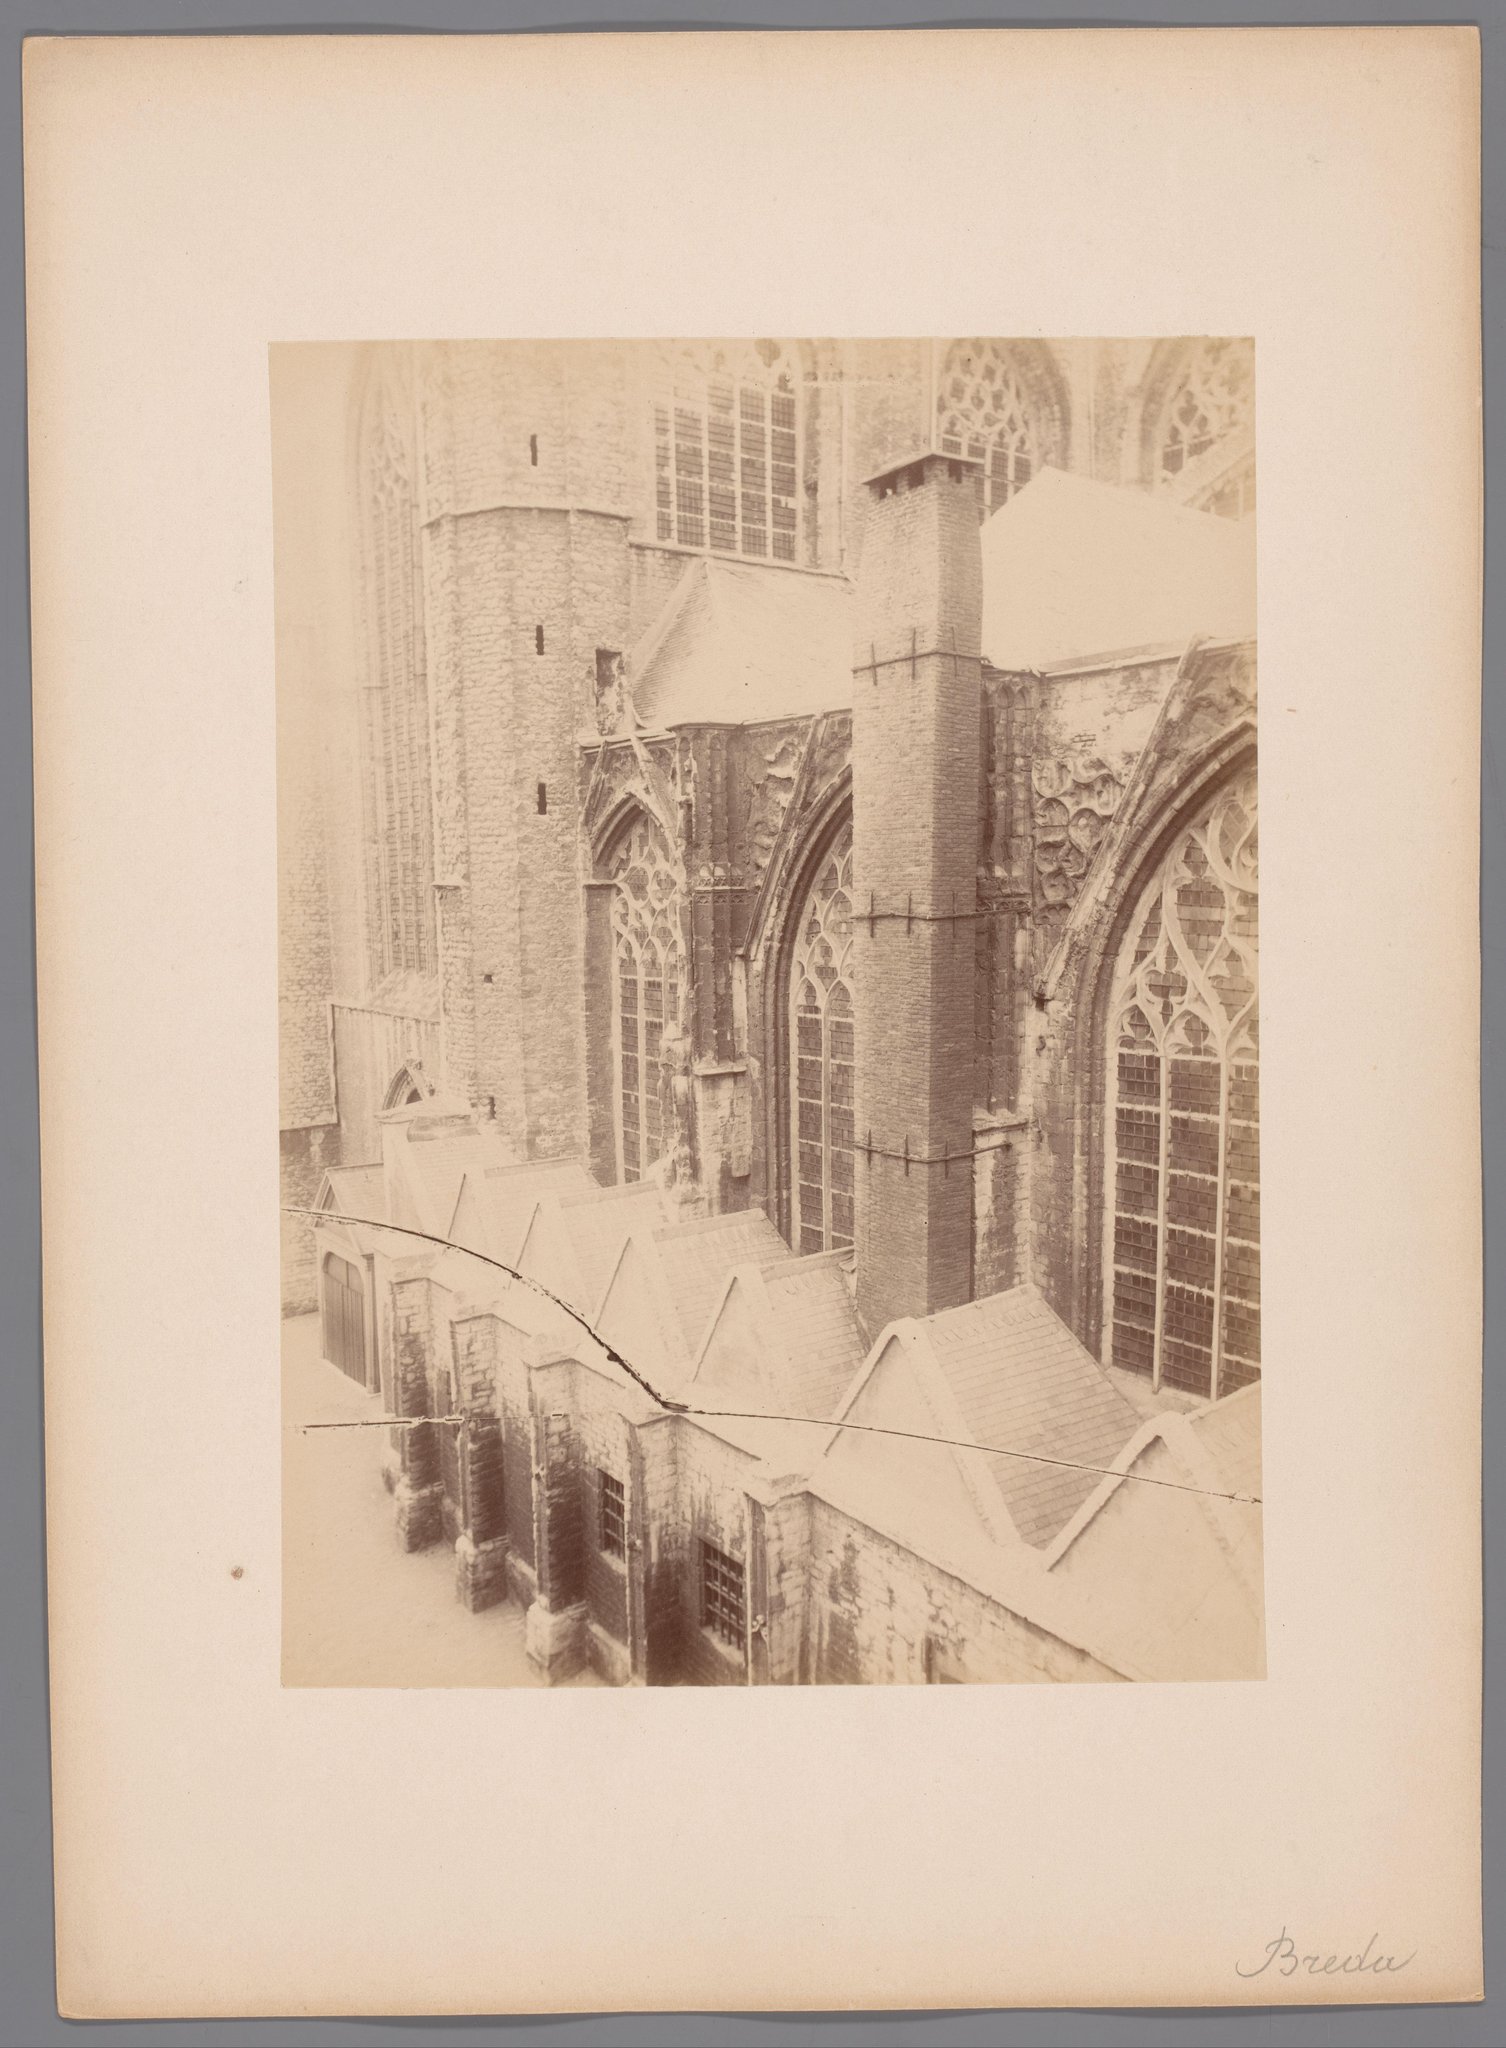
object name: photograph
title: Zuidzijde van de Grote Kerk te Breda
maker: anoniem (monumentenzorg)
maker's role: fotograaf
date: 1890-1920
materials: cardboard, photographic support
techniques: albumen print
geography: breda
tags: church (exterior)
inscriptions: annotation: ‘N.H. Kerk te Breda/ Zuidzijde rechts van transept/ [...]’, annotation: ‘Breda’